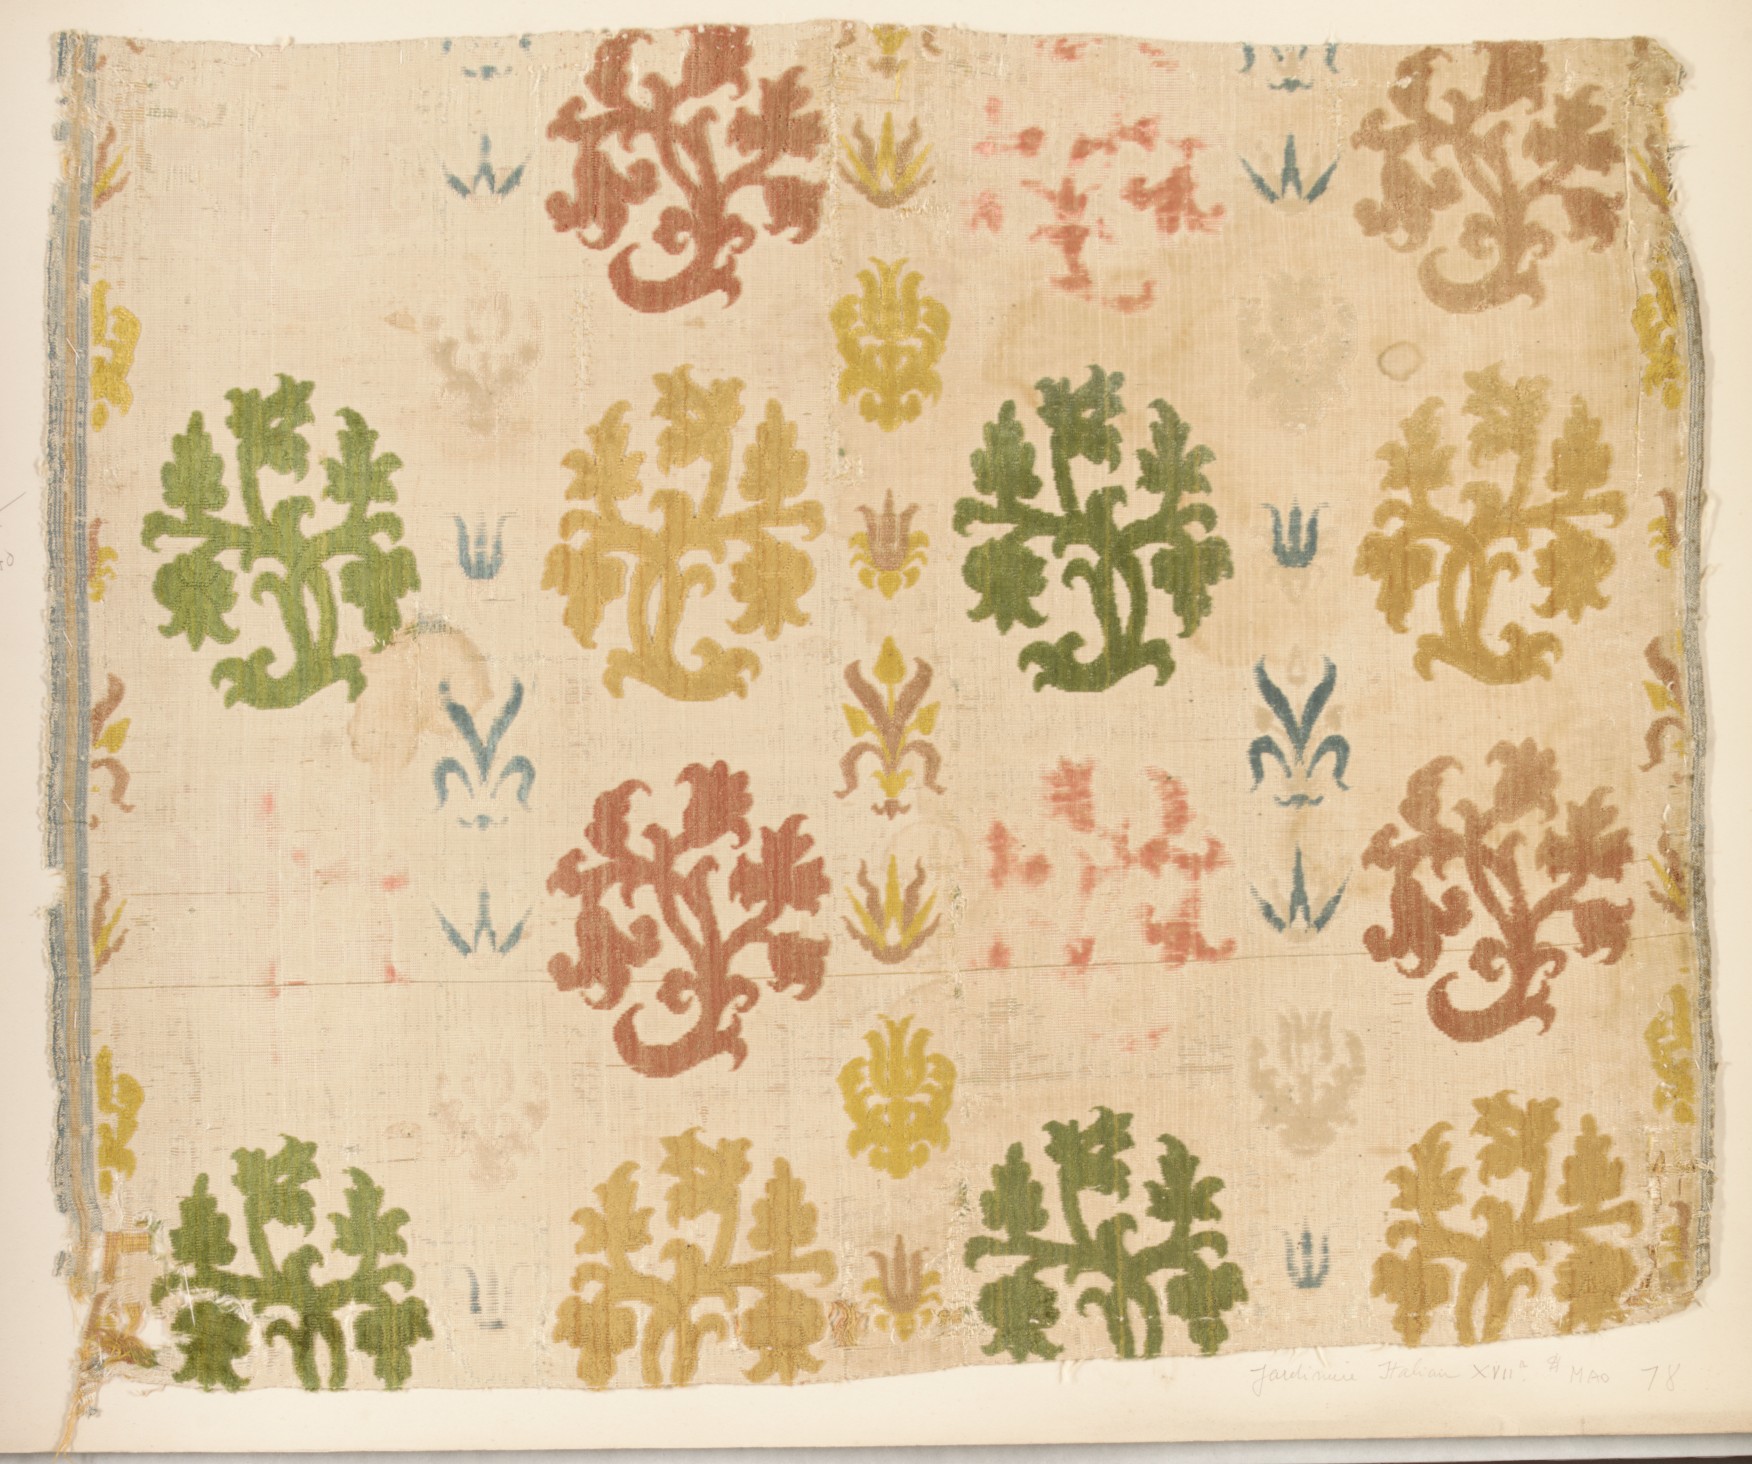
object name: fragment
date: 1601-1700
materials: silk